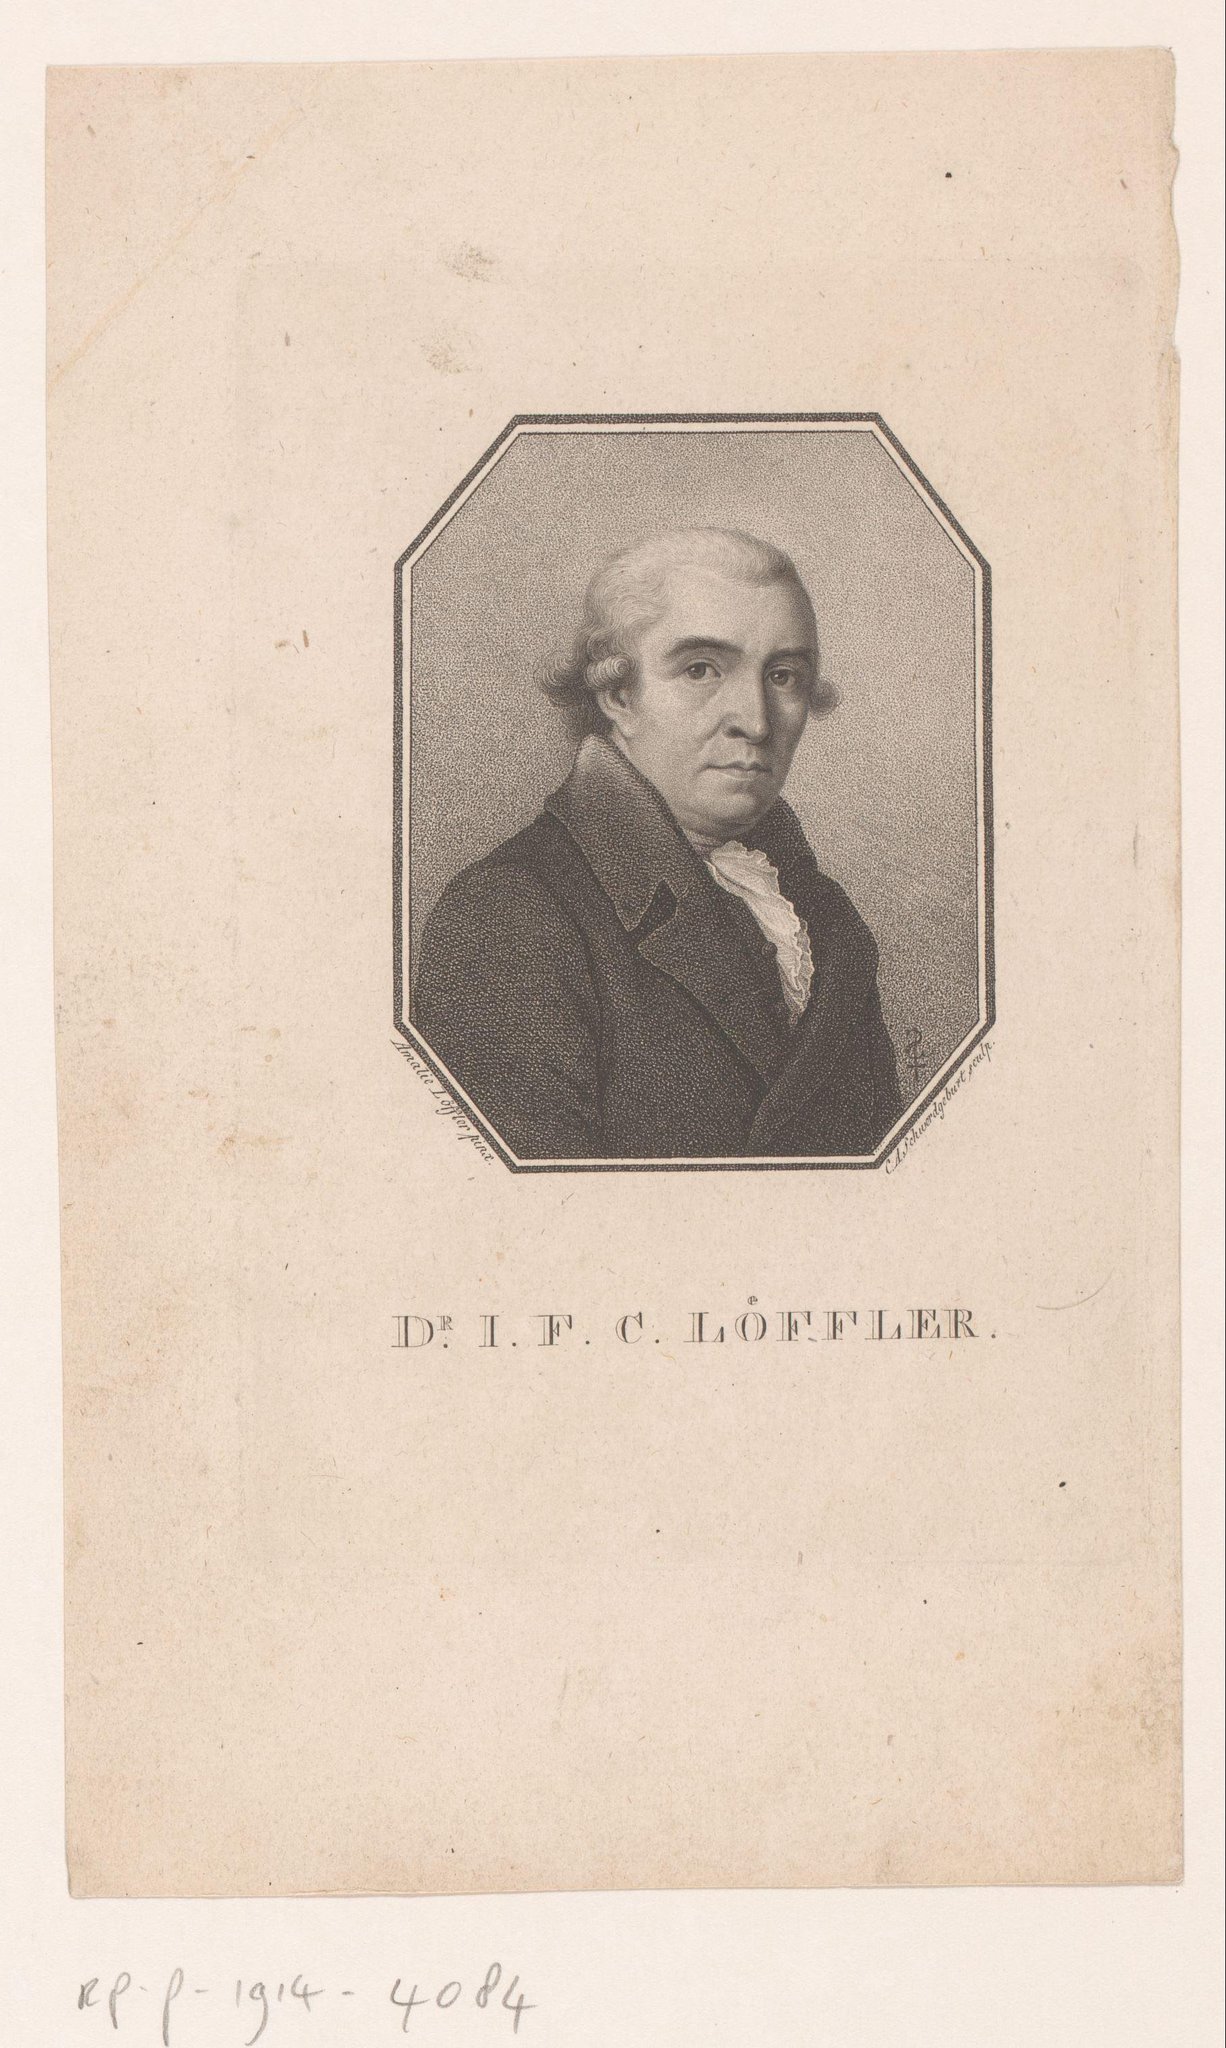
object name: print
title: Portret van Josias Friedrich Christian Löffler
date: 1795-1878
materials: paper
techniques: engraving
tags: theologian, historical persons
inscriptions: collector's mark: Lugt 2228